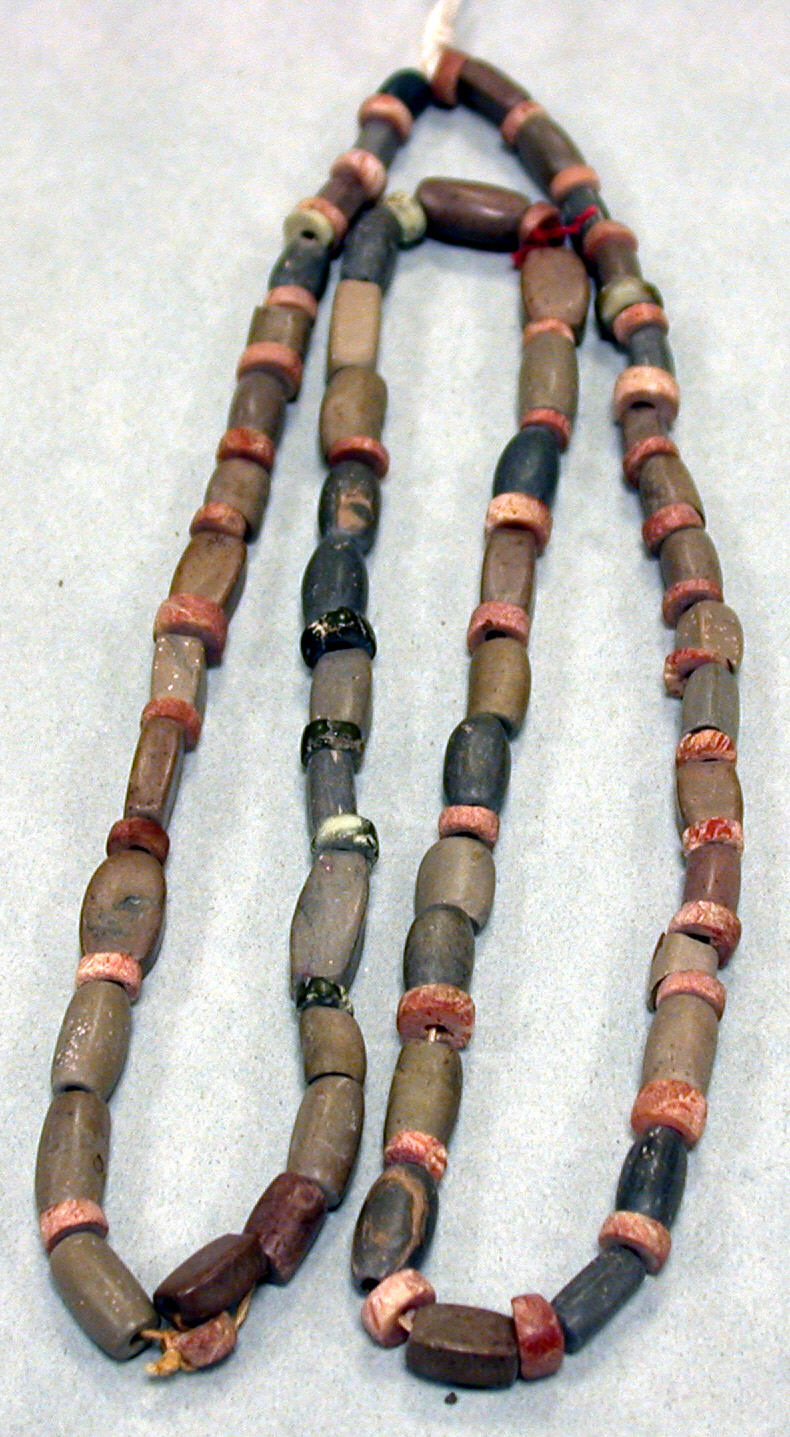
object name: bead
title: Beaded Necklace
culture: peruvian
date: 1-1566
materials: shell, stone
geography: peru